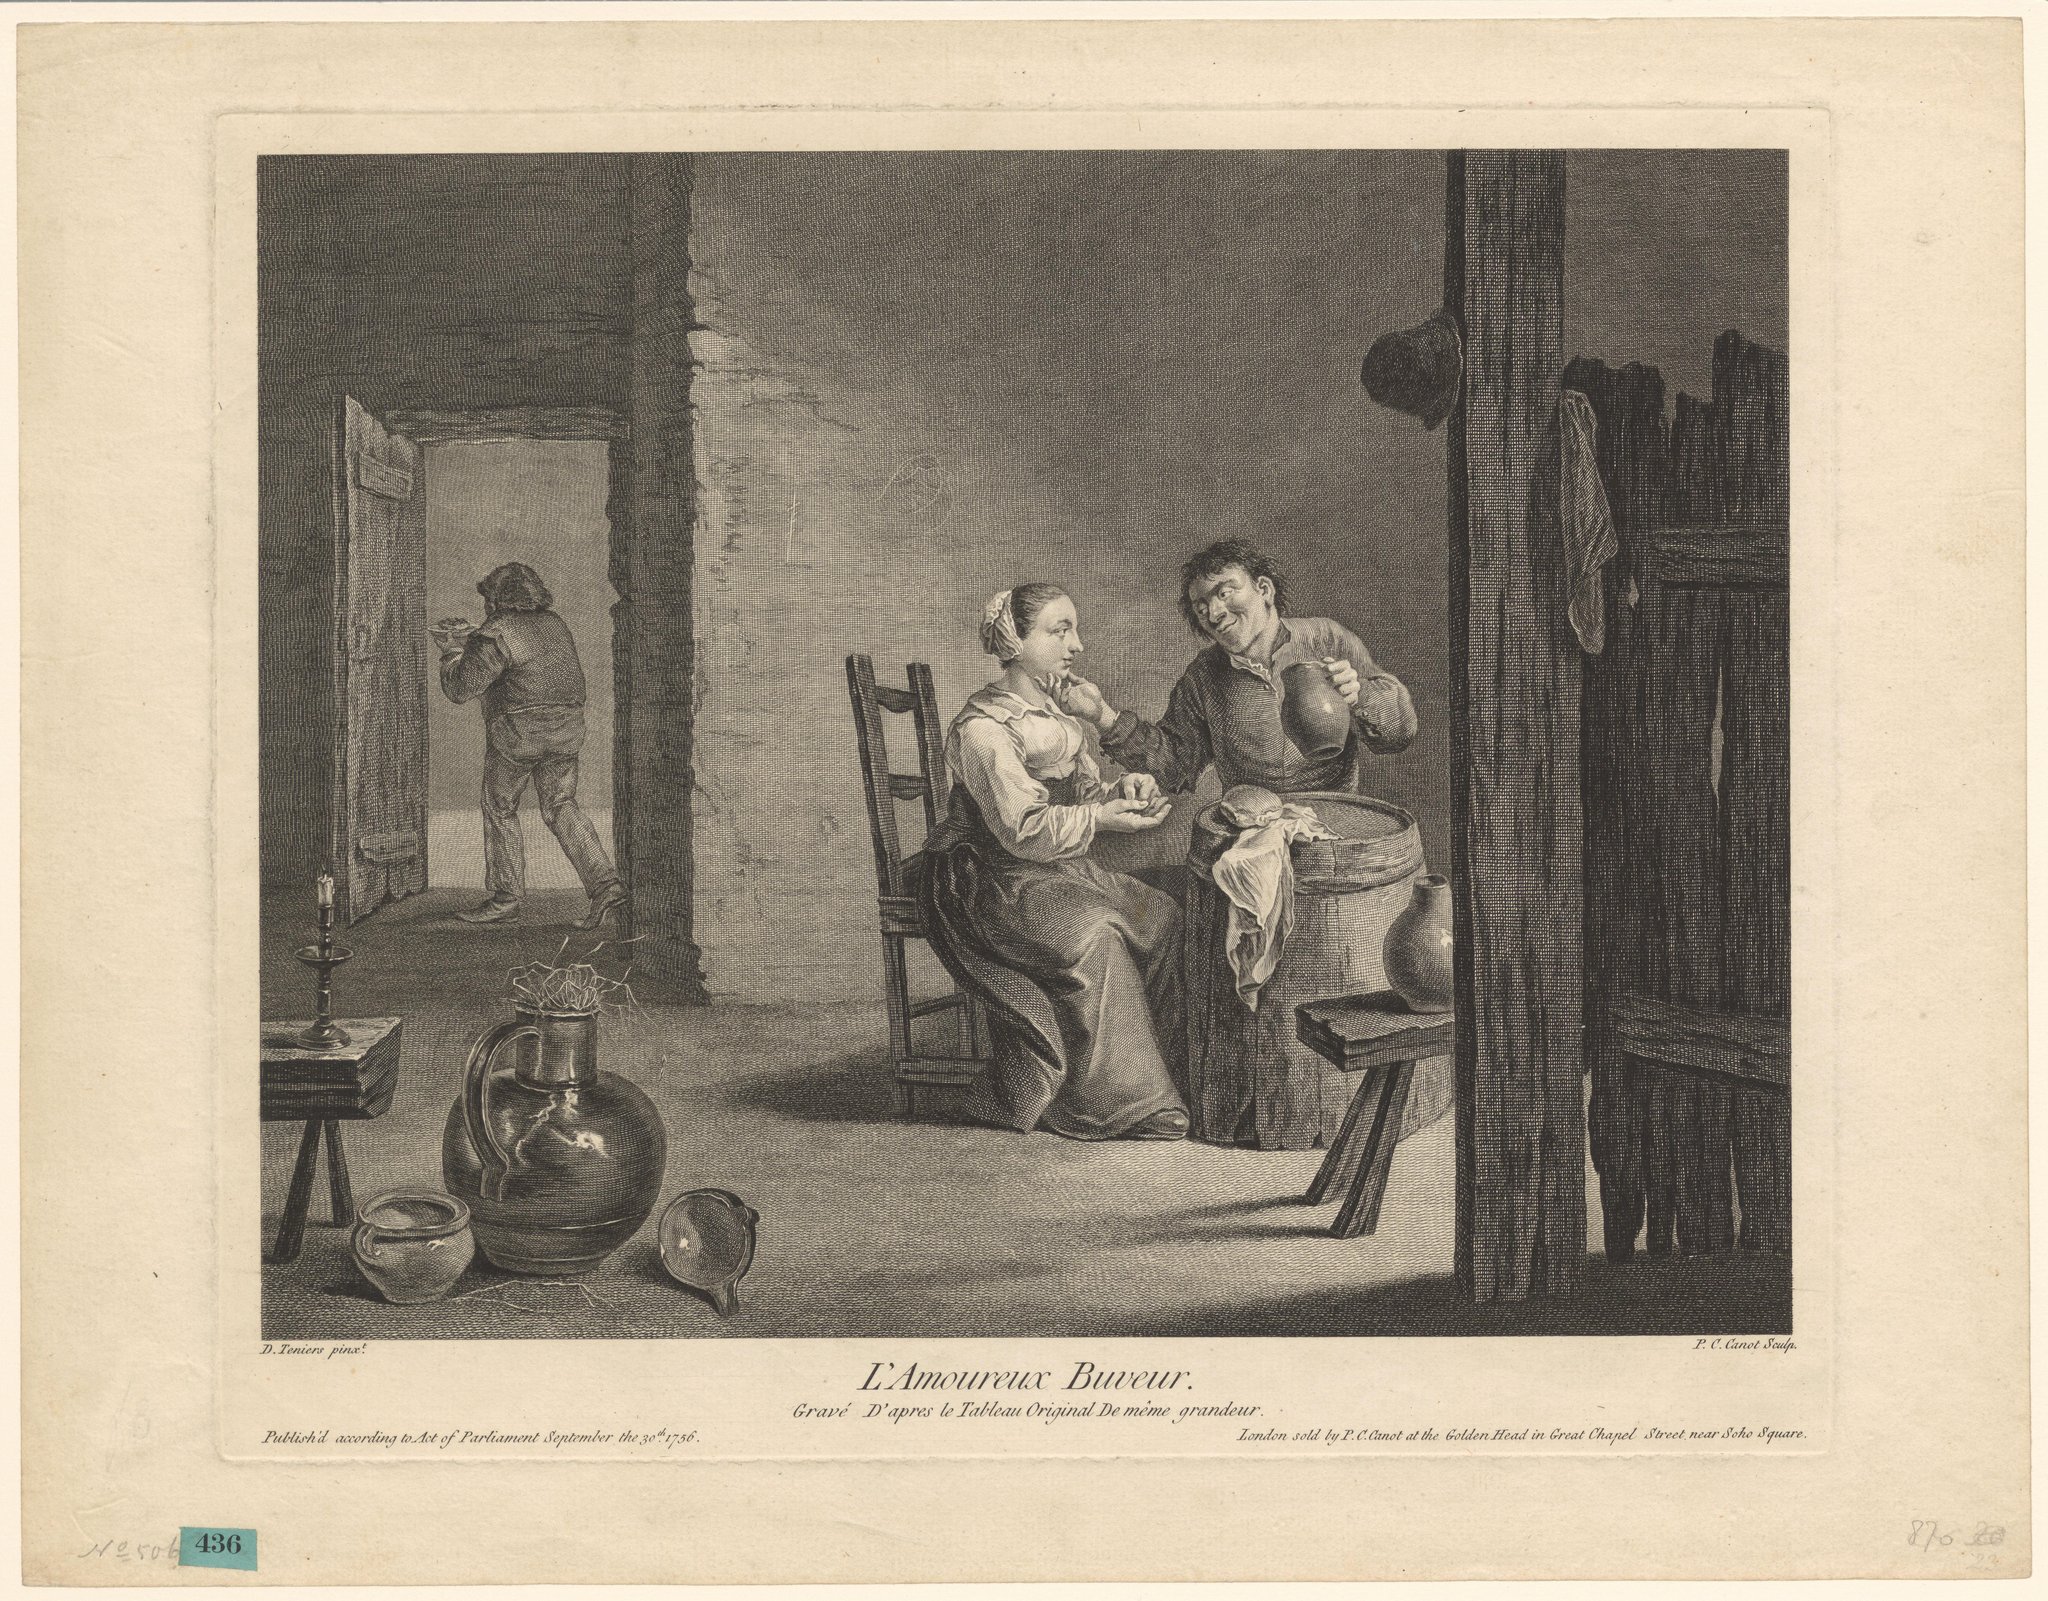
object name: print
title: L'Amour Buveur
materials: paper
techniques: etching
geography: london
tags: drunkard, inn, coffee-house, public house, etc., couple of lovers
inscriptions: collector's mark: Lugt 2228, collector's mark: Lugt 2028